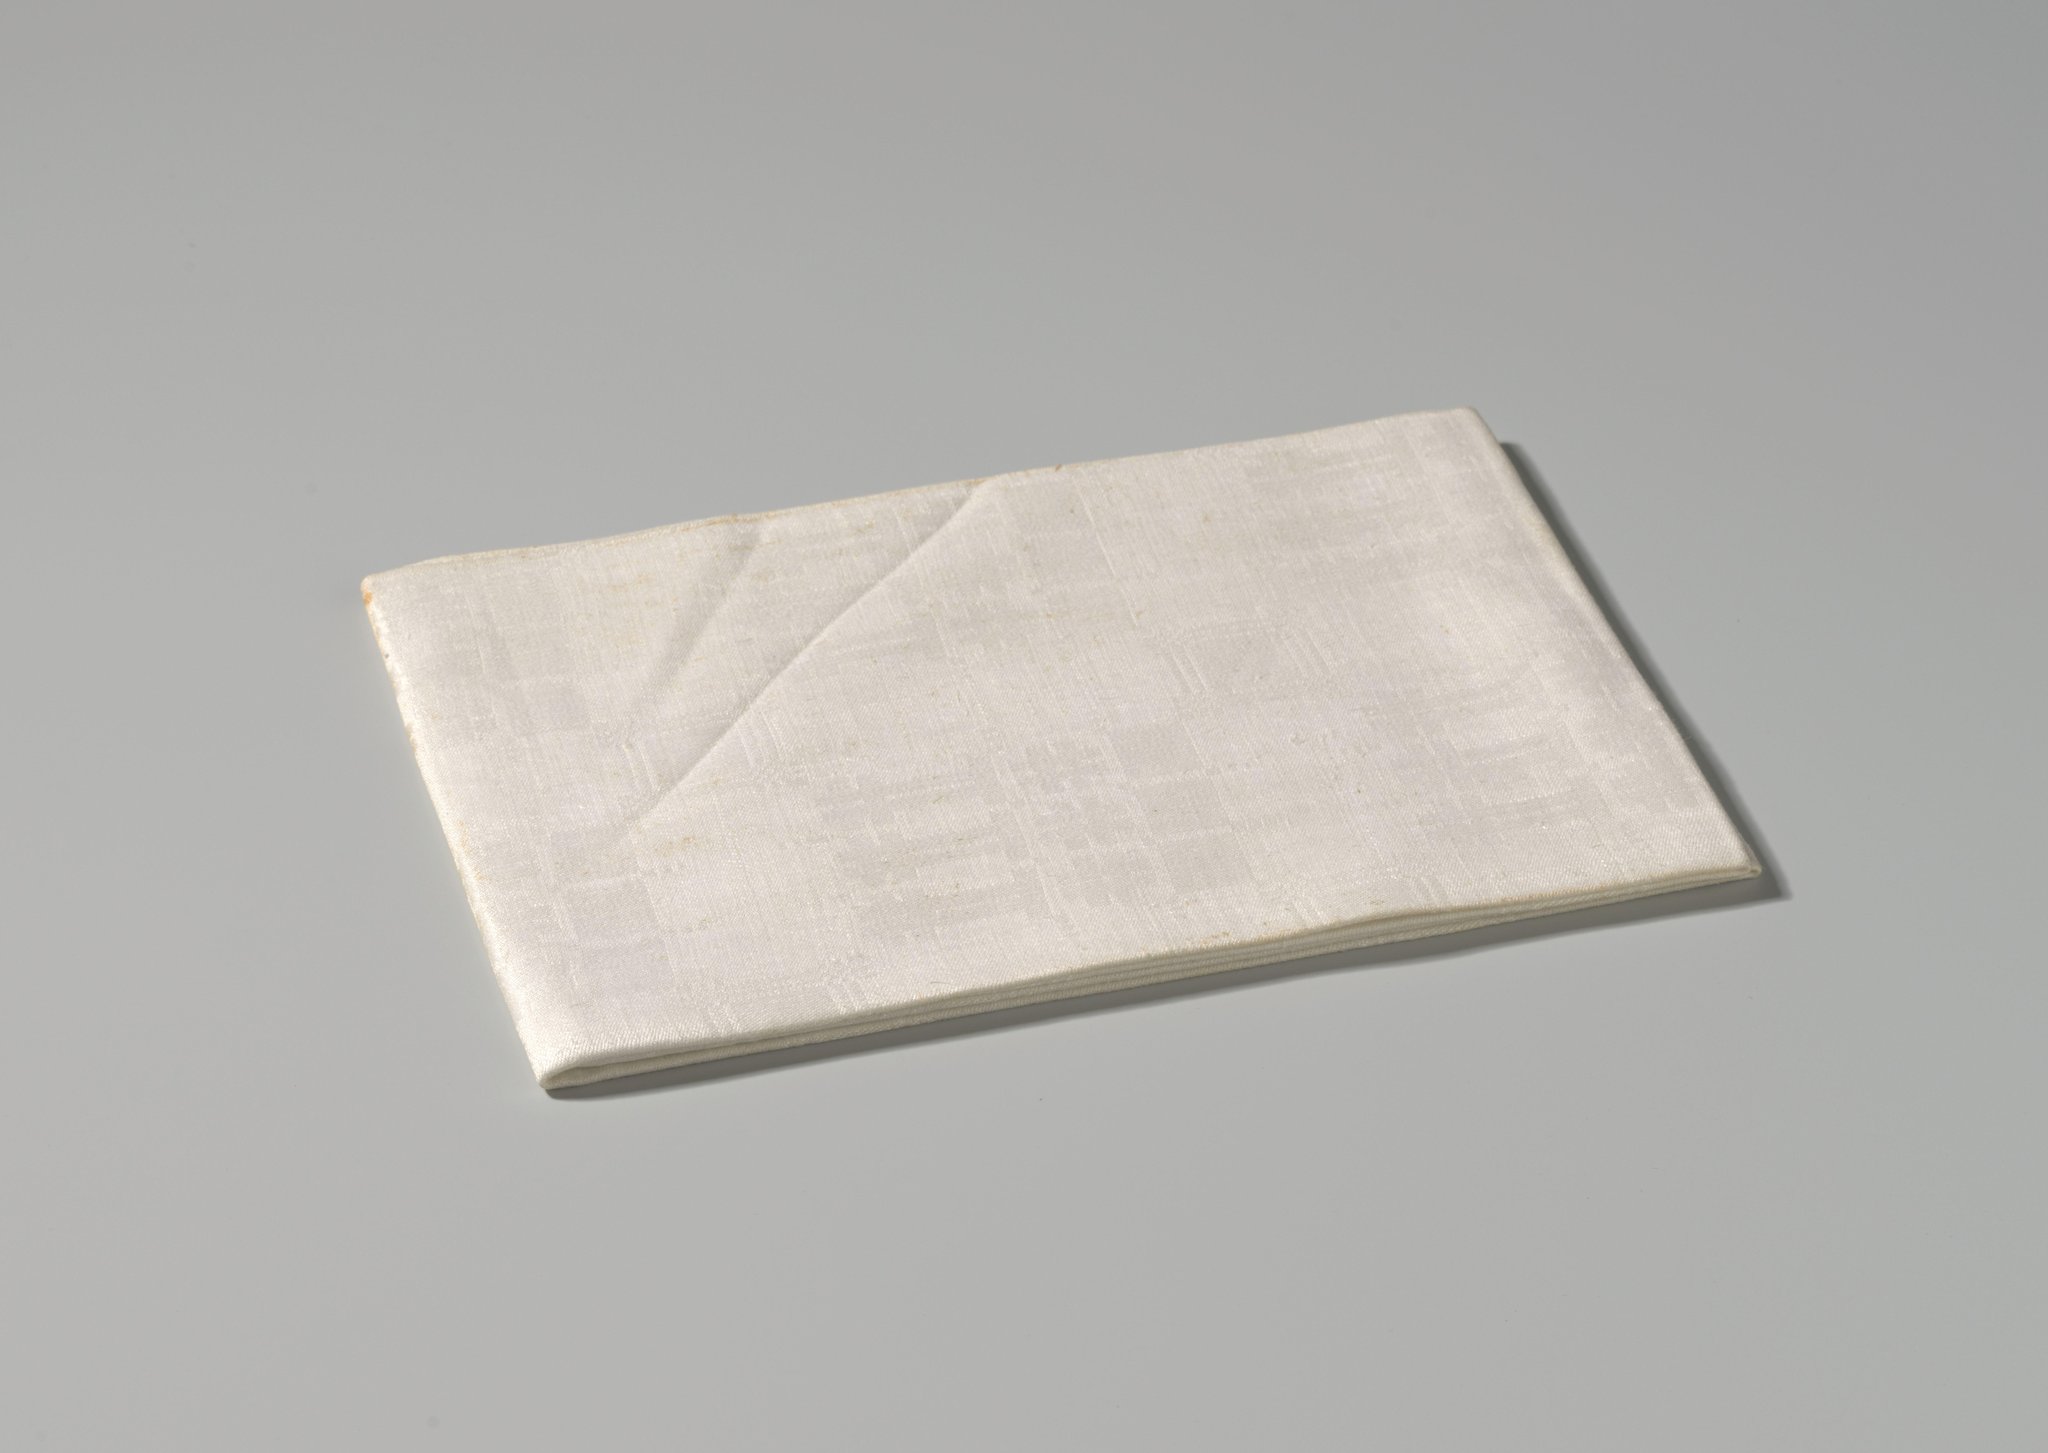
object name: napkin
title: Servet van linnen met pellenpatroon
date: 1725-1769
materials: linen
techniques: peeled fabric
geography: northern netherlands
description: wit linnen servet met pellen patroon, merk kroon ARVG 31